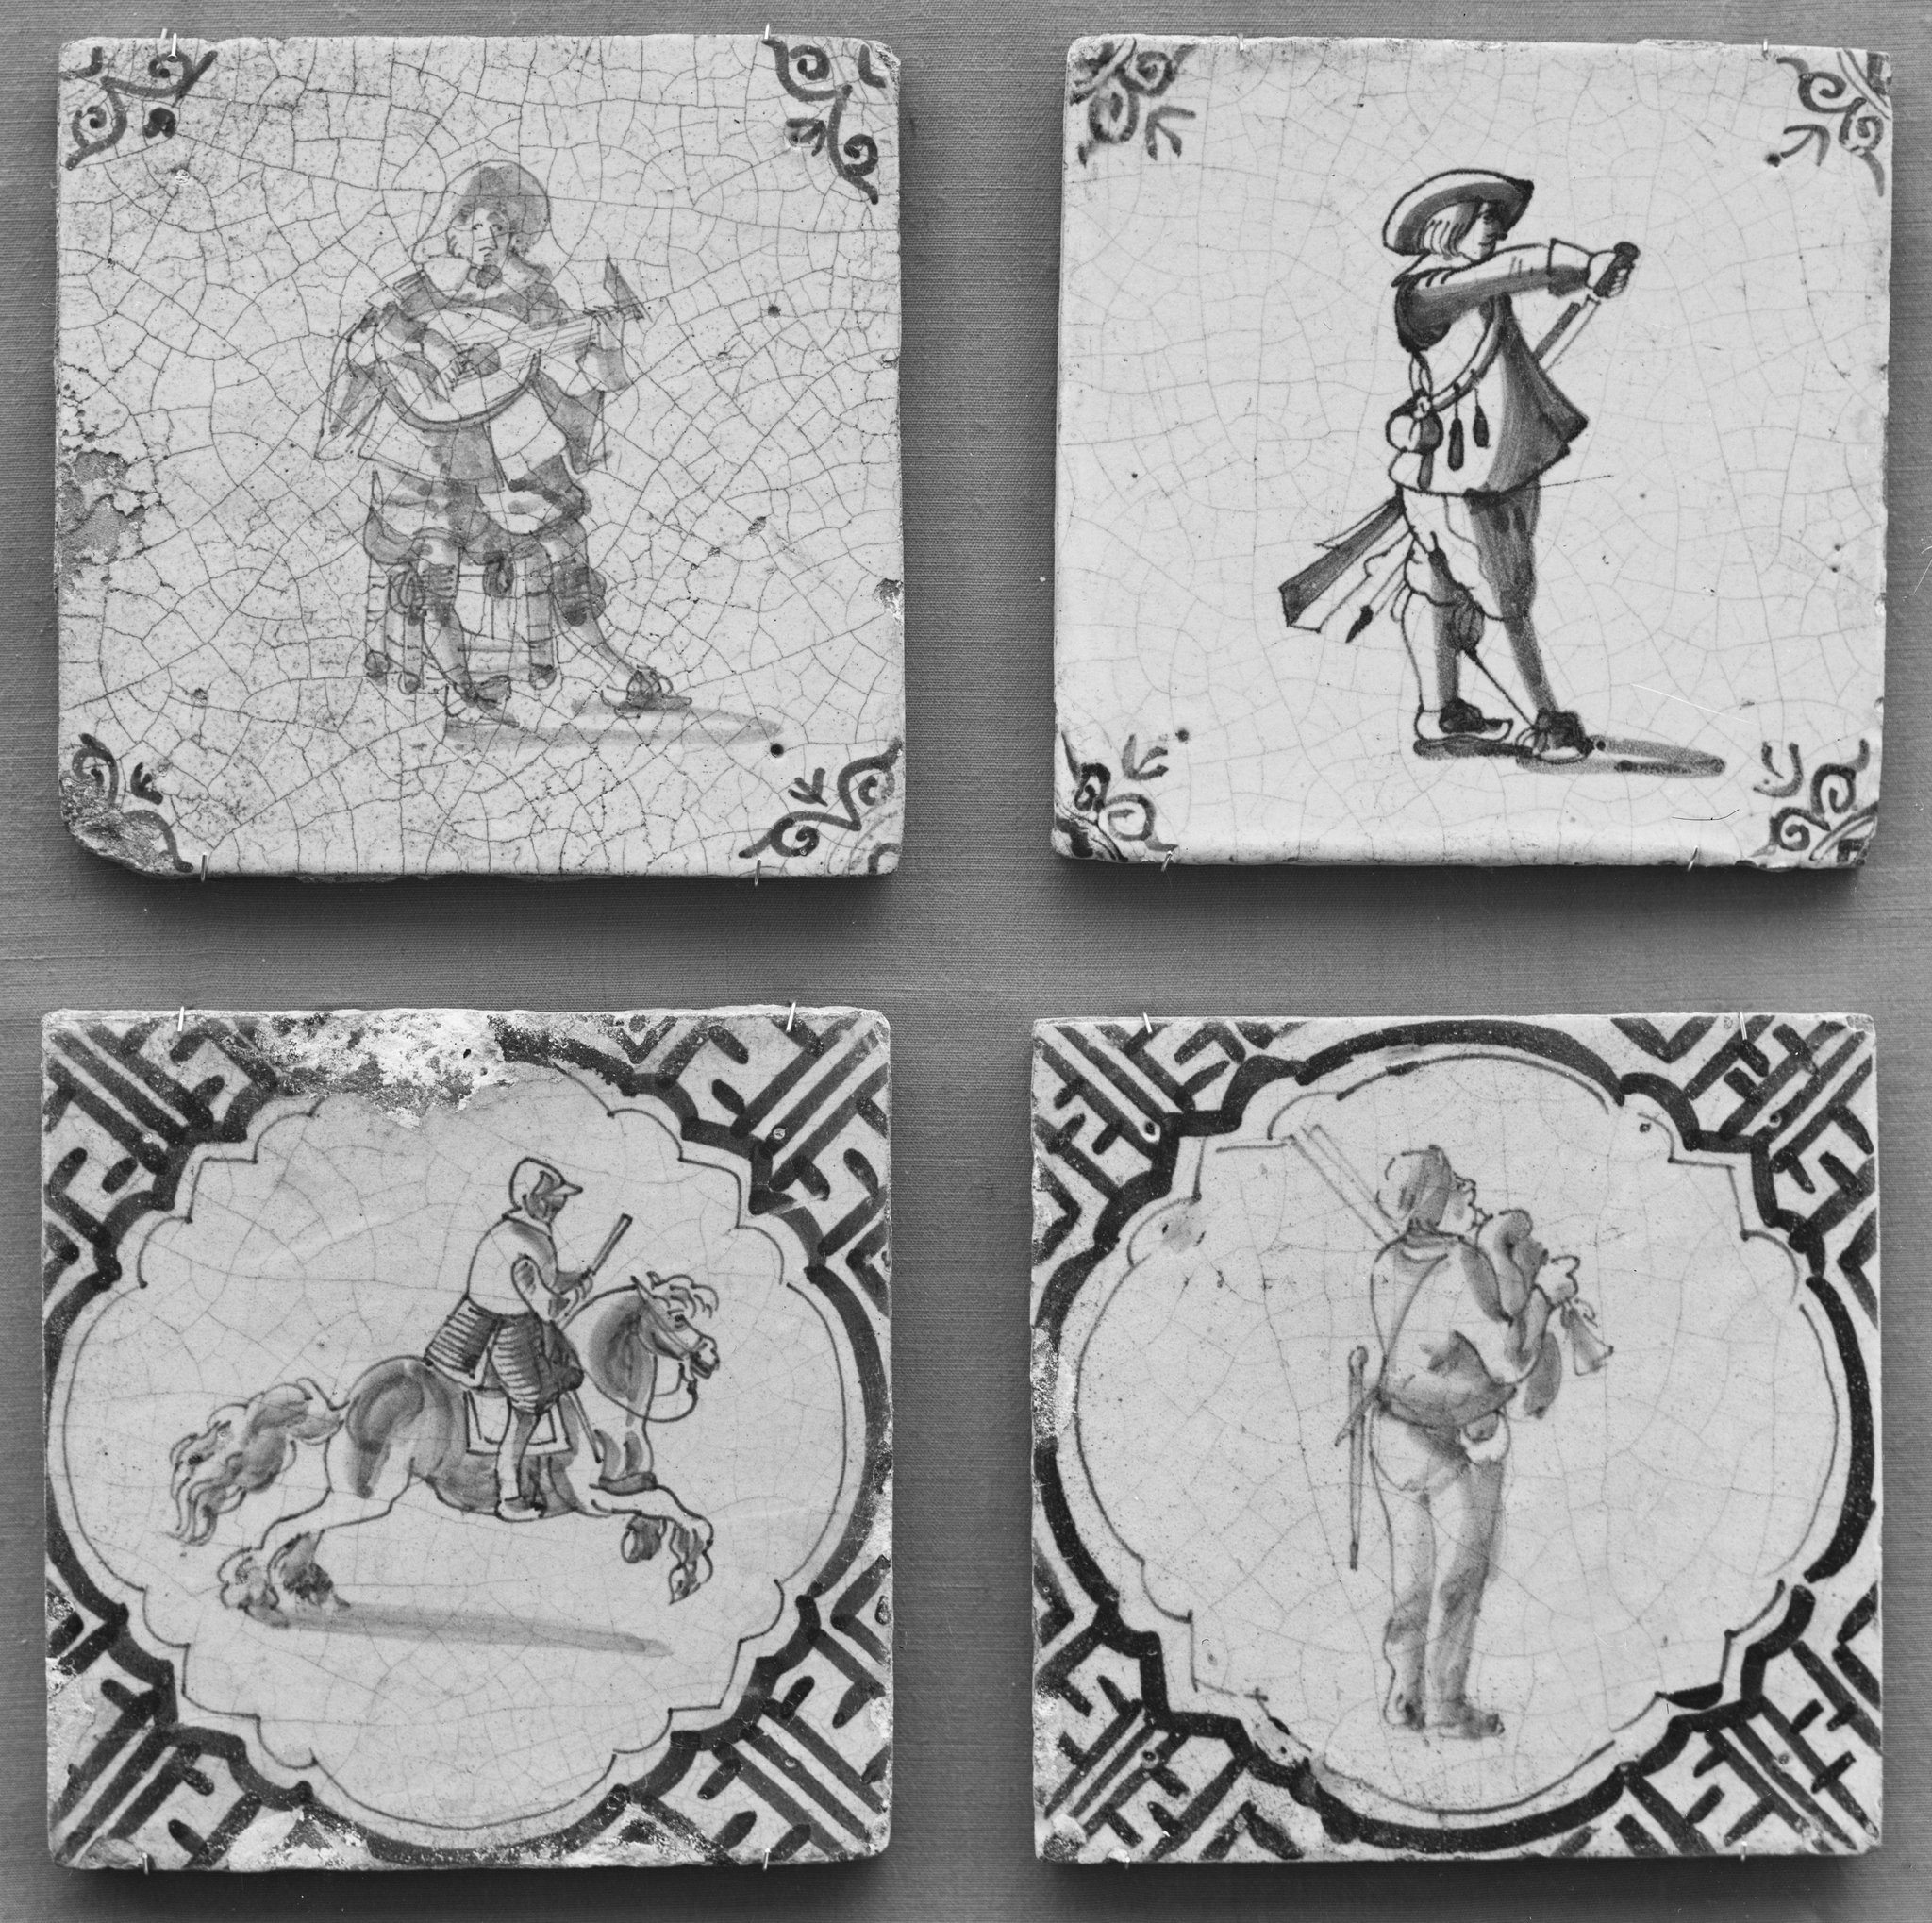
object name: tile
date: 1620-1640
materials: earthenware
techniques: glazing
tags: men,horses